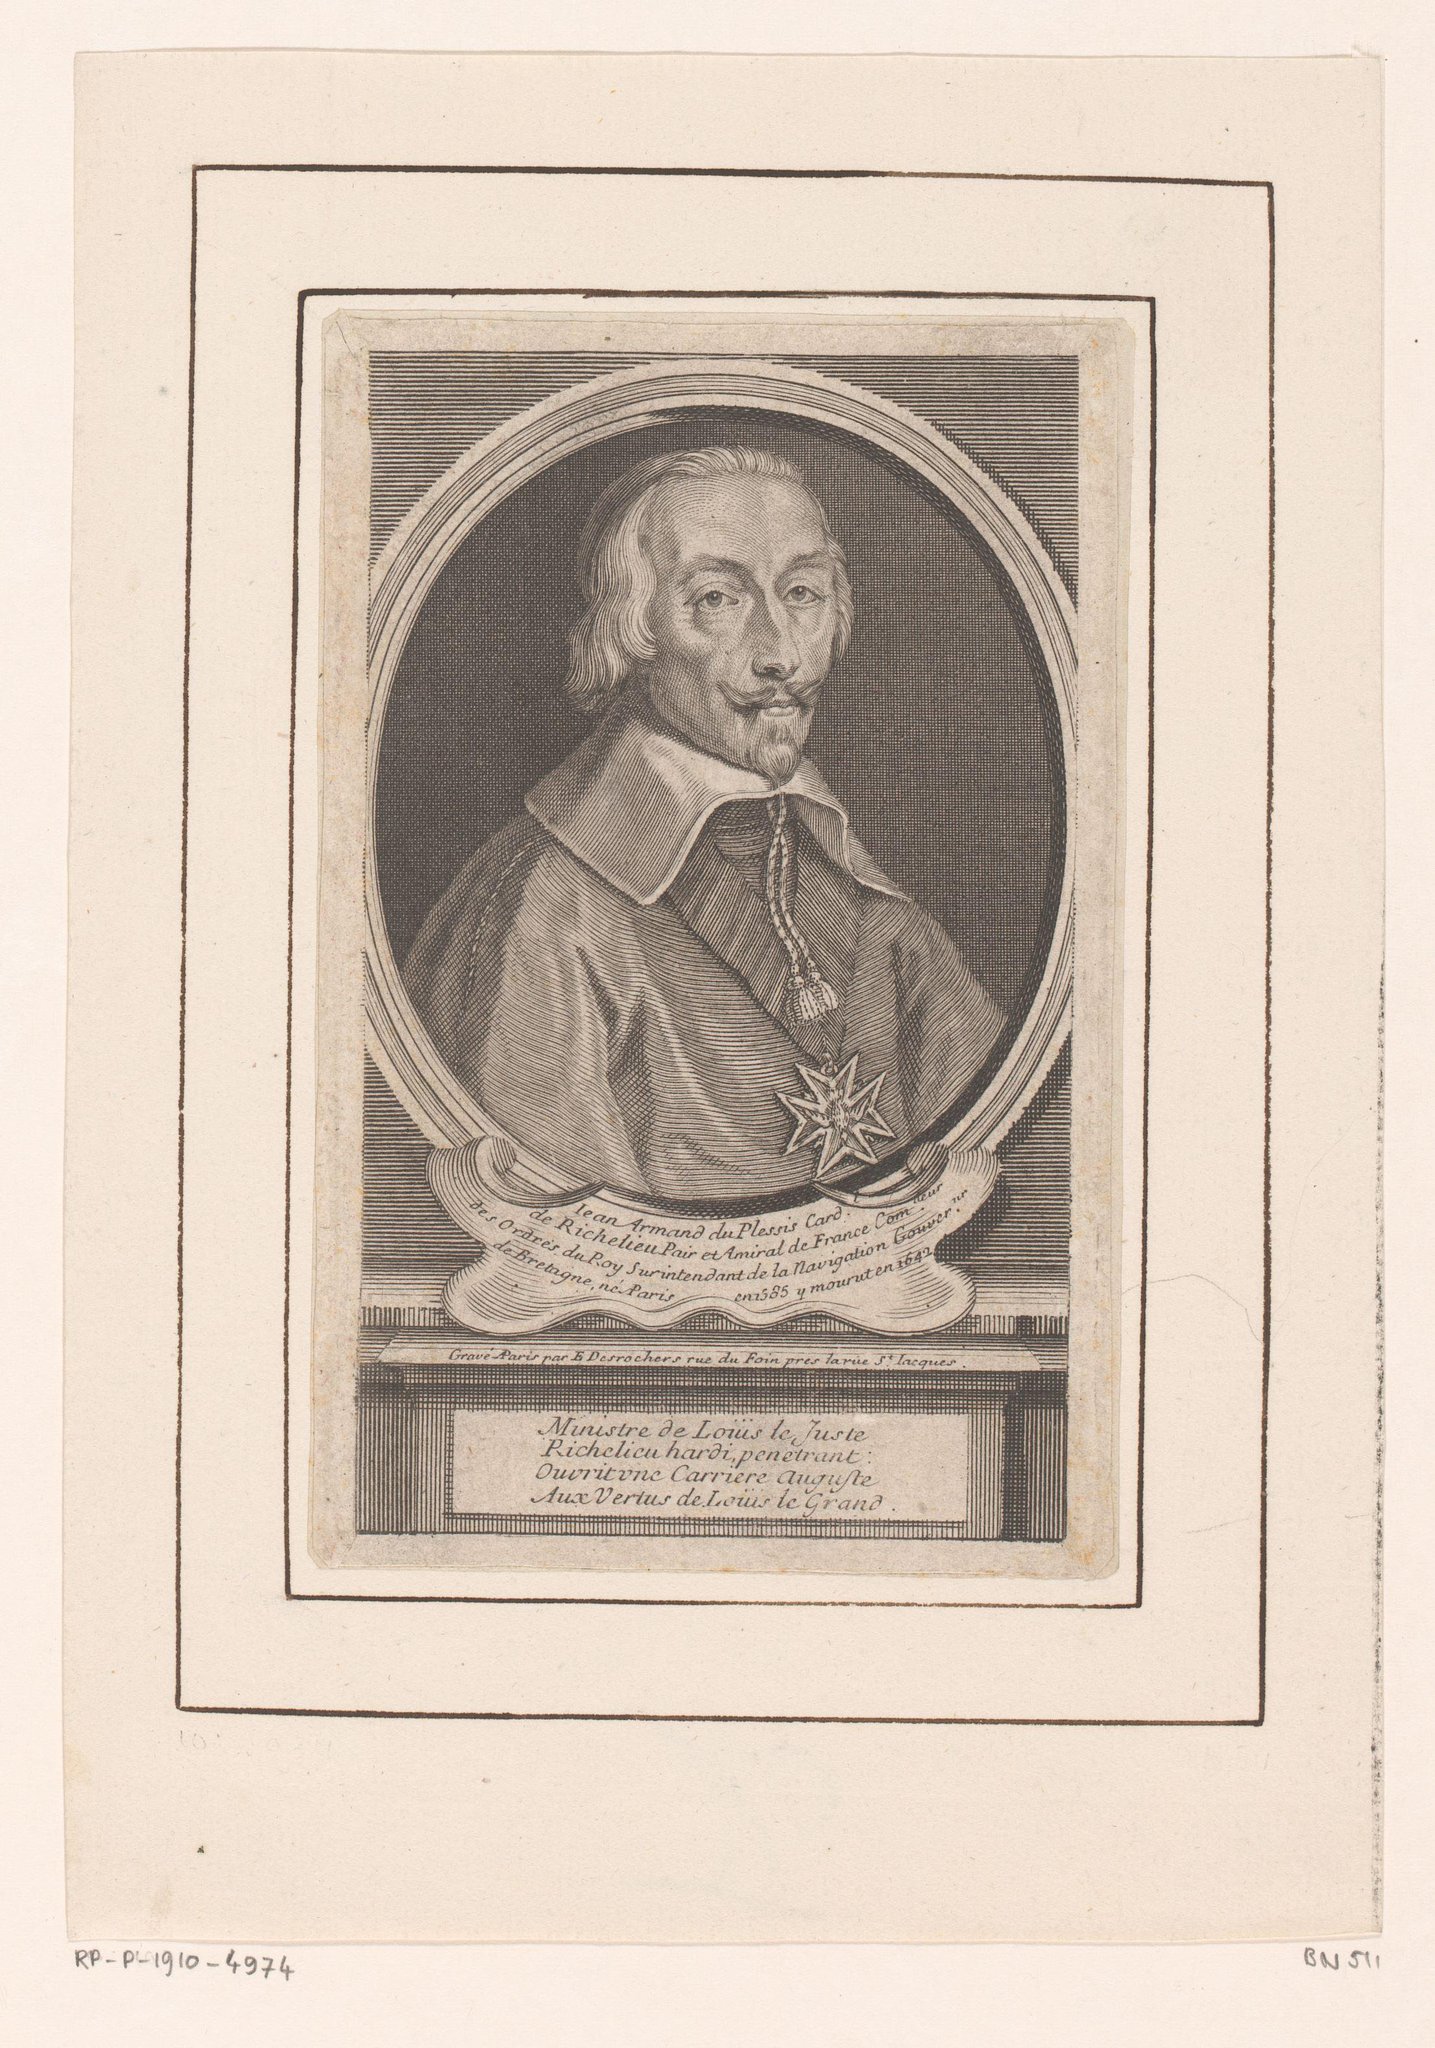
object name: print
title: Portret van Armand-Jean du Plessis hertog van Richelieu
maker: étienne desrochers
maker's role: print maker, publisher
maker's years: 1668-1741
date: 1726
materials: ink, paper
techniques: engraving, etching, pen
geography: paris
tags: paris, armand-jean du plessis hertog van richelieu, cardinal, historical persons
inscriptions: collector's mark: Lugt 2228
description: Behoort waarschijnlijk tot een serie portretten, grotendeels door Etienne Desrochers, getiteld: 'Recueil de portraits de personnes qui se sont distinguées tant dans les Armes que dans Belles-Lettres et les Arts, comme aussi la famille royale de France et autres cours étrangères'. De serie werd initieel uitgegeven door Desrochers en aangekondigd in 'Mercure' in mei 1726, p. 985. Echter was Desrochers reeds enkele jaren eerder begonnen met het uitgeven van de serie. Na de dood van Desrochers werd de serie voortgezet door Gilles Edme Petit. Een latere staat werd uitgegeven door Jean François Daumont in Parijs.